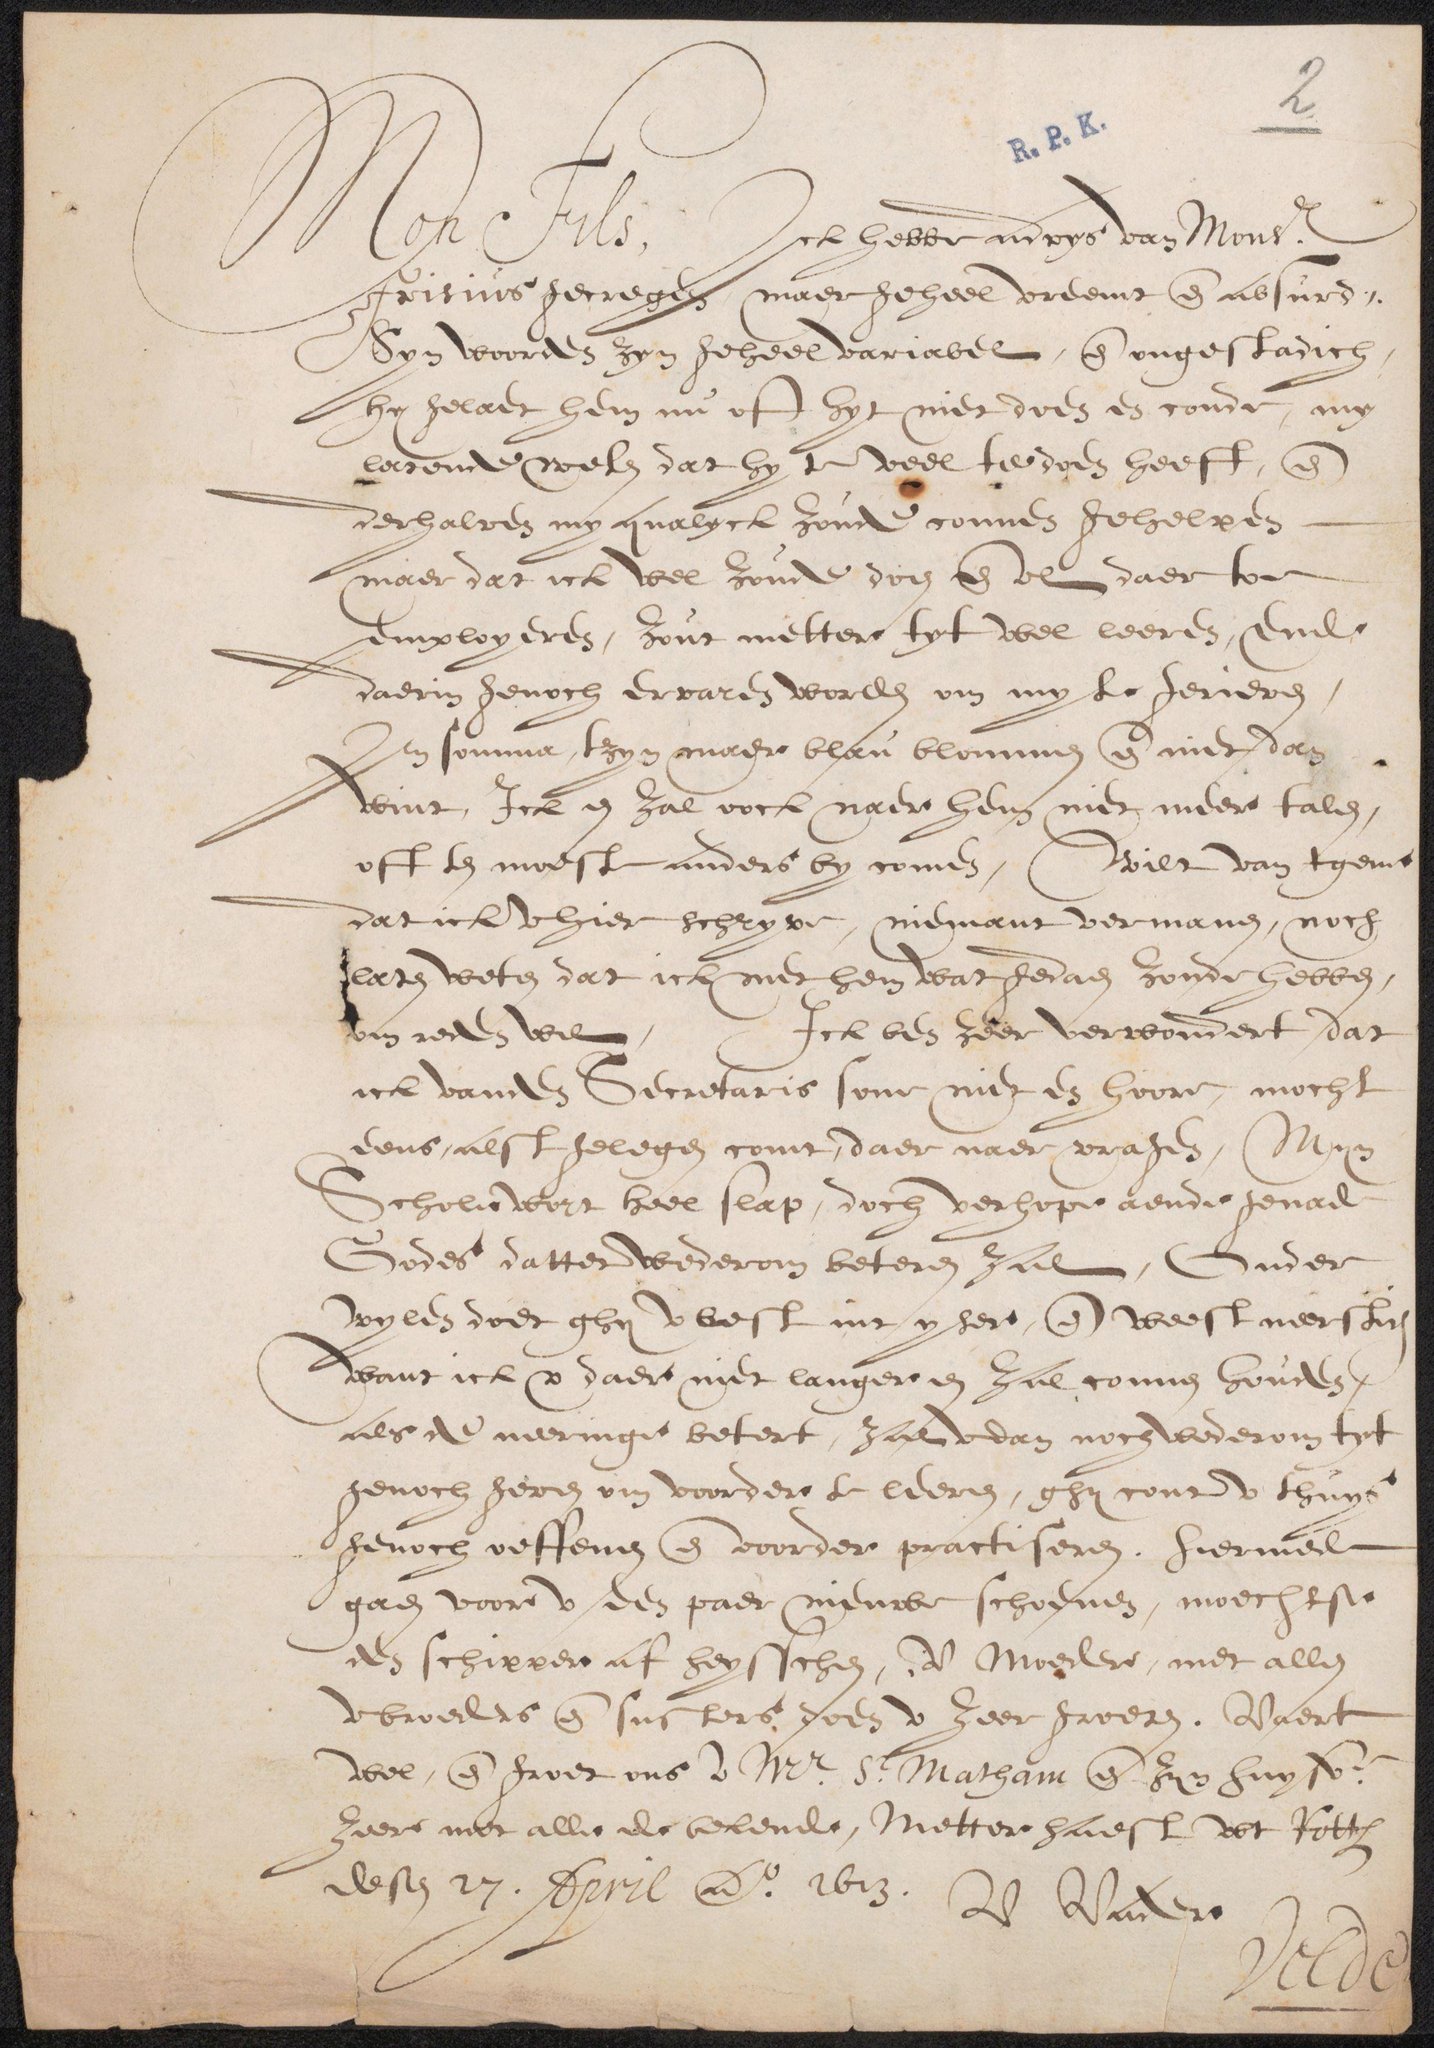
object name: letter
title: Brief aan Jan van de Velde (II)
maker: jan van de velde (i)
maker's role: painter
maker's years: 1568-1623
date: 1613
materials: ink, paper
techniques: pen, writing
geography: rotterdam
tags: harlingen, the hague, print maker, simon frisius, draughtsman, jacob matham, enkhuizen, jan van de velde (ii), passions, emotions, affections, the graphic arts, education, tuition of the artist (in general)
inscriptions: collector's mark: Lugt 2233, watermark